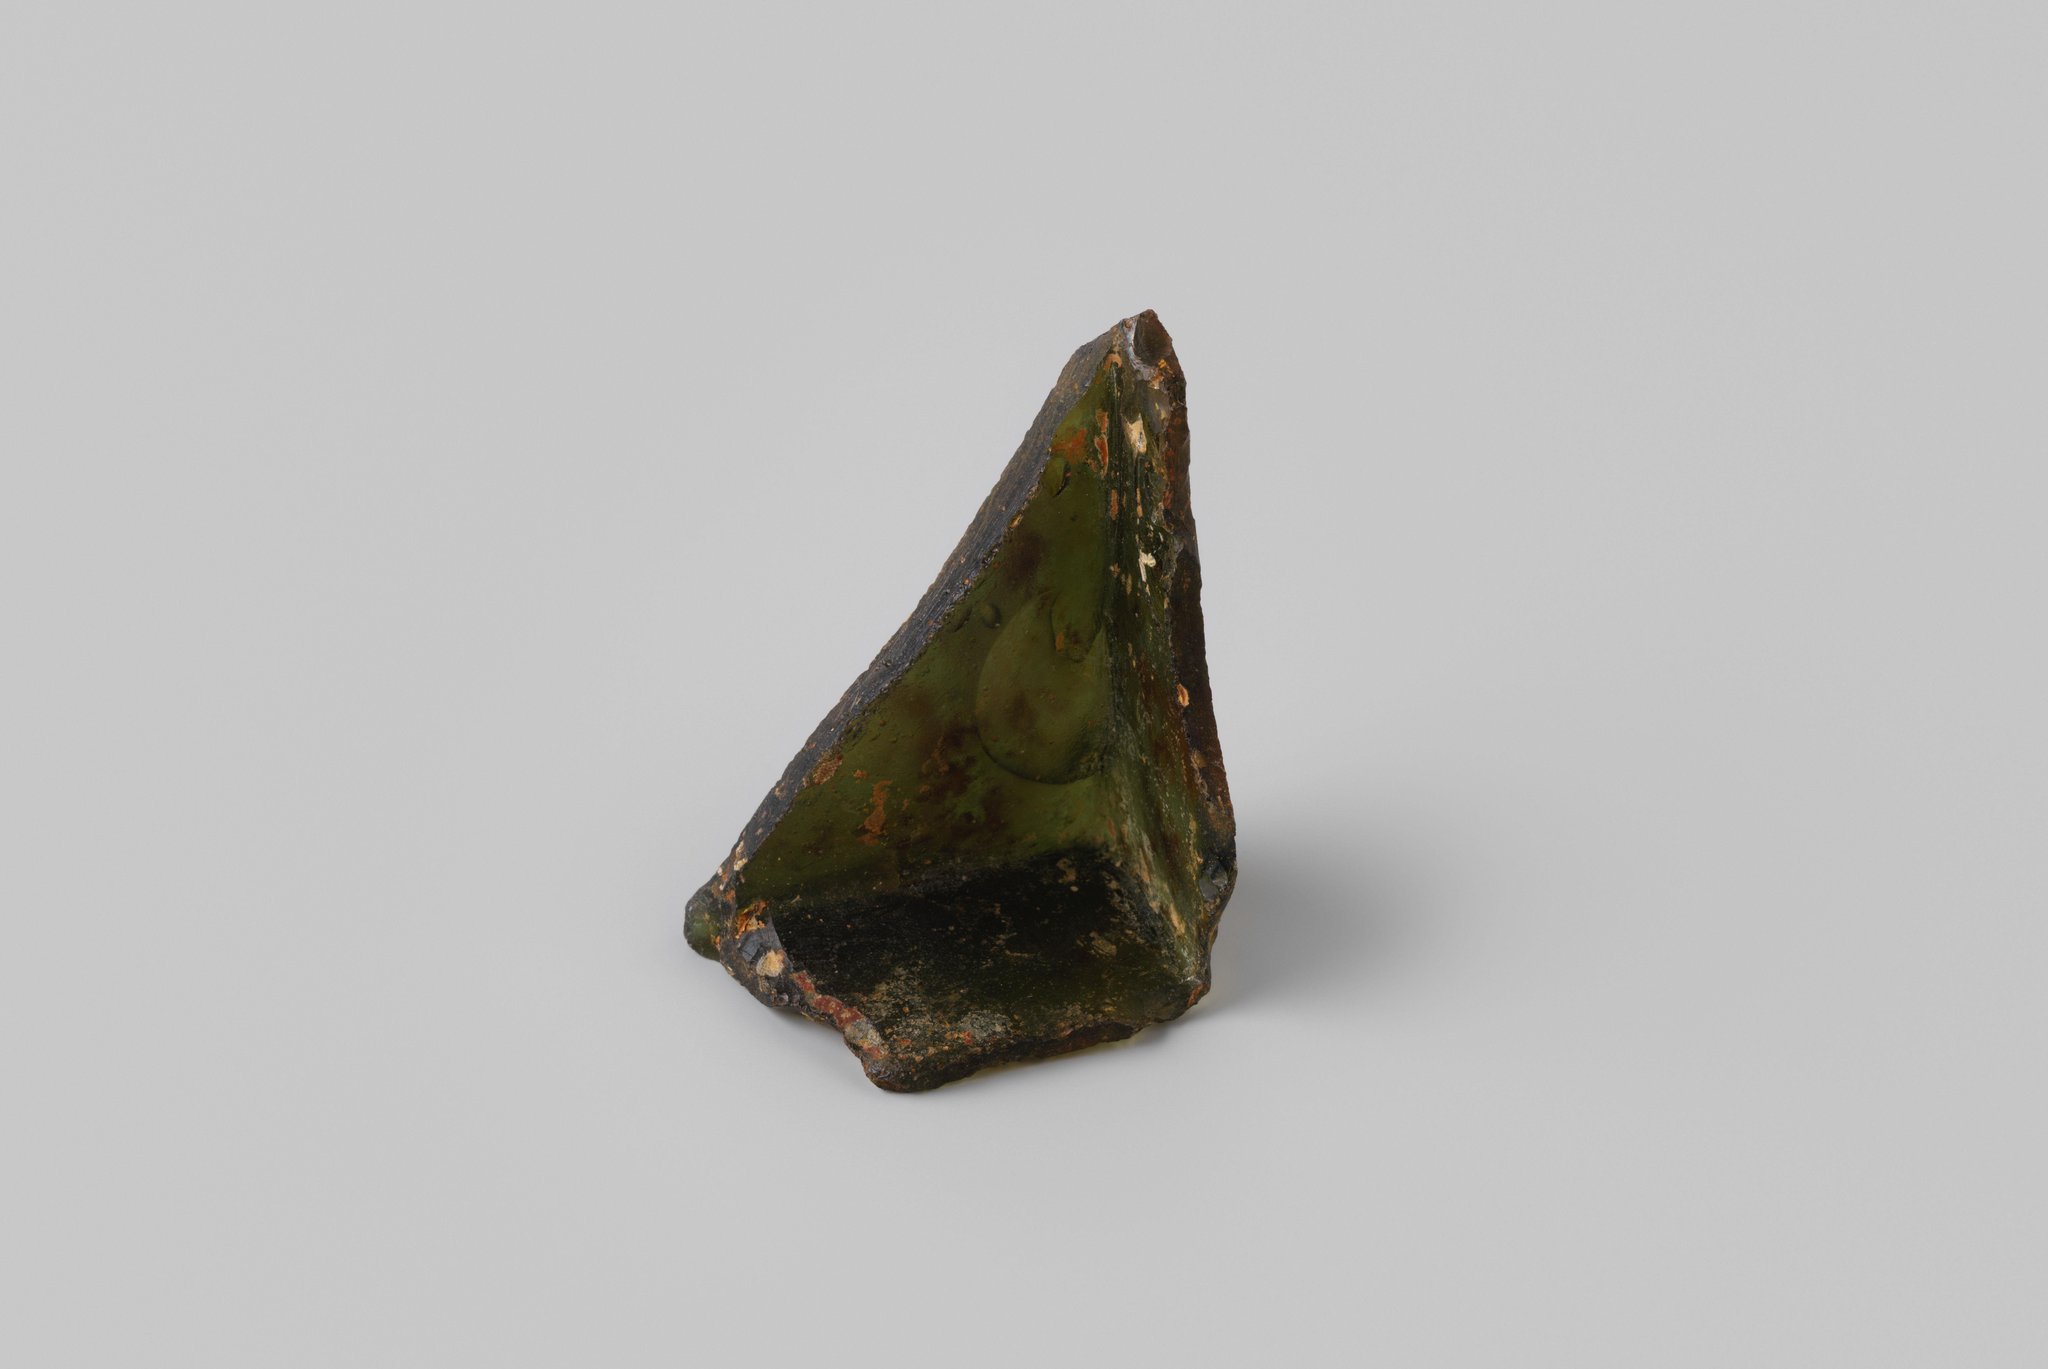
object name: sherd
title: Fragment kelderfles uit het wrak van de Oost-Indiëvaarder Hollandia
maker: Anonymous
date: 1700-1743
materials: glass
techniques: green glass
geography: netherlands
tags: verenigde oostindische compagnie, hollandia (schip), annet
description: Case bottle, fragm of base, corner, sim. NG 1980-27H1872b.